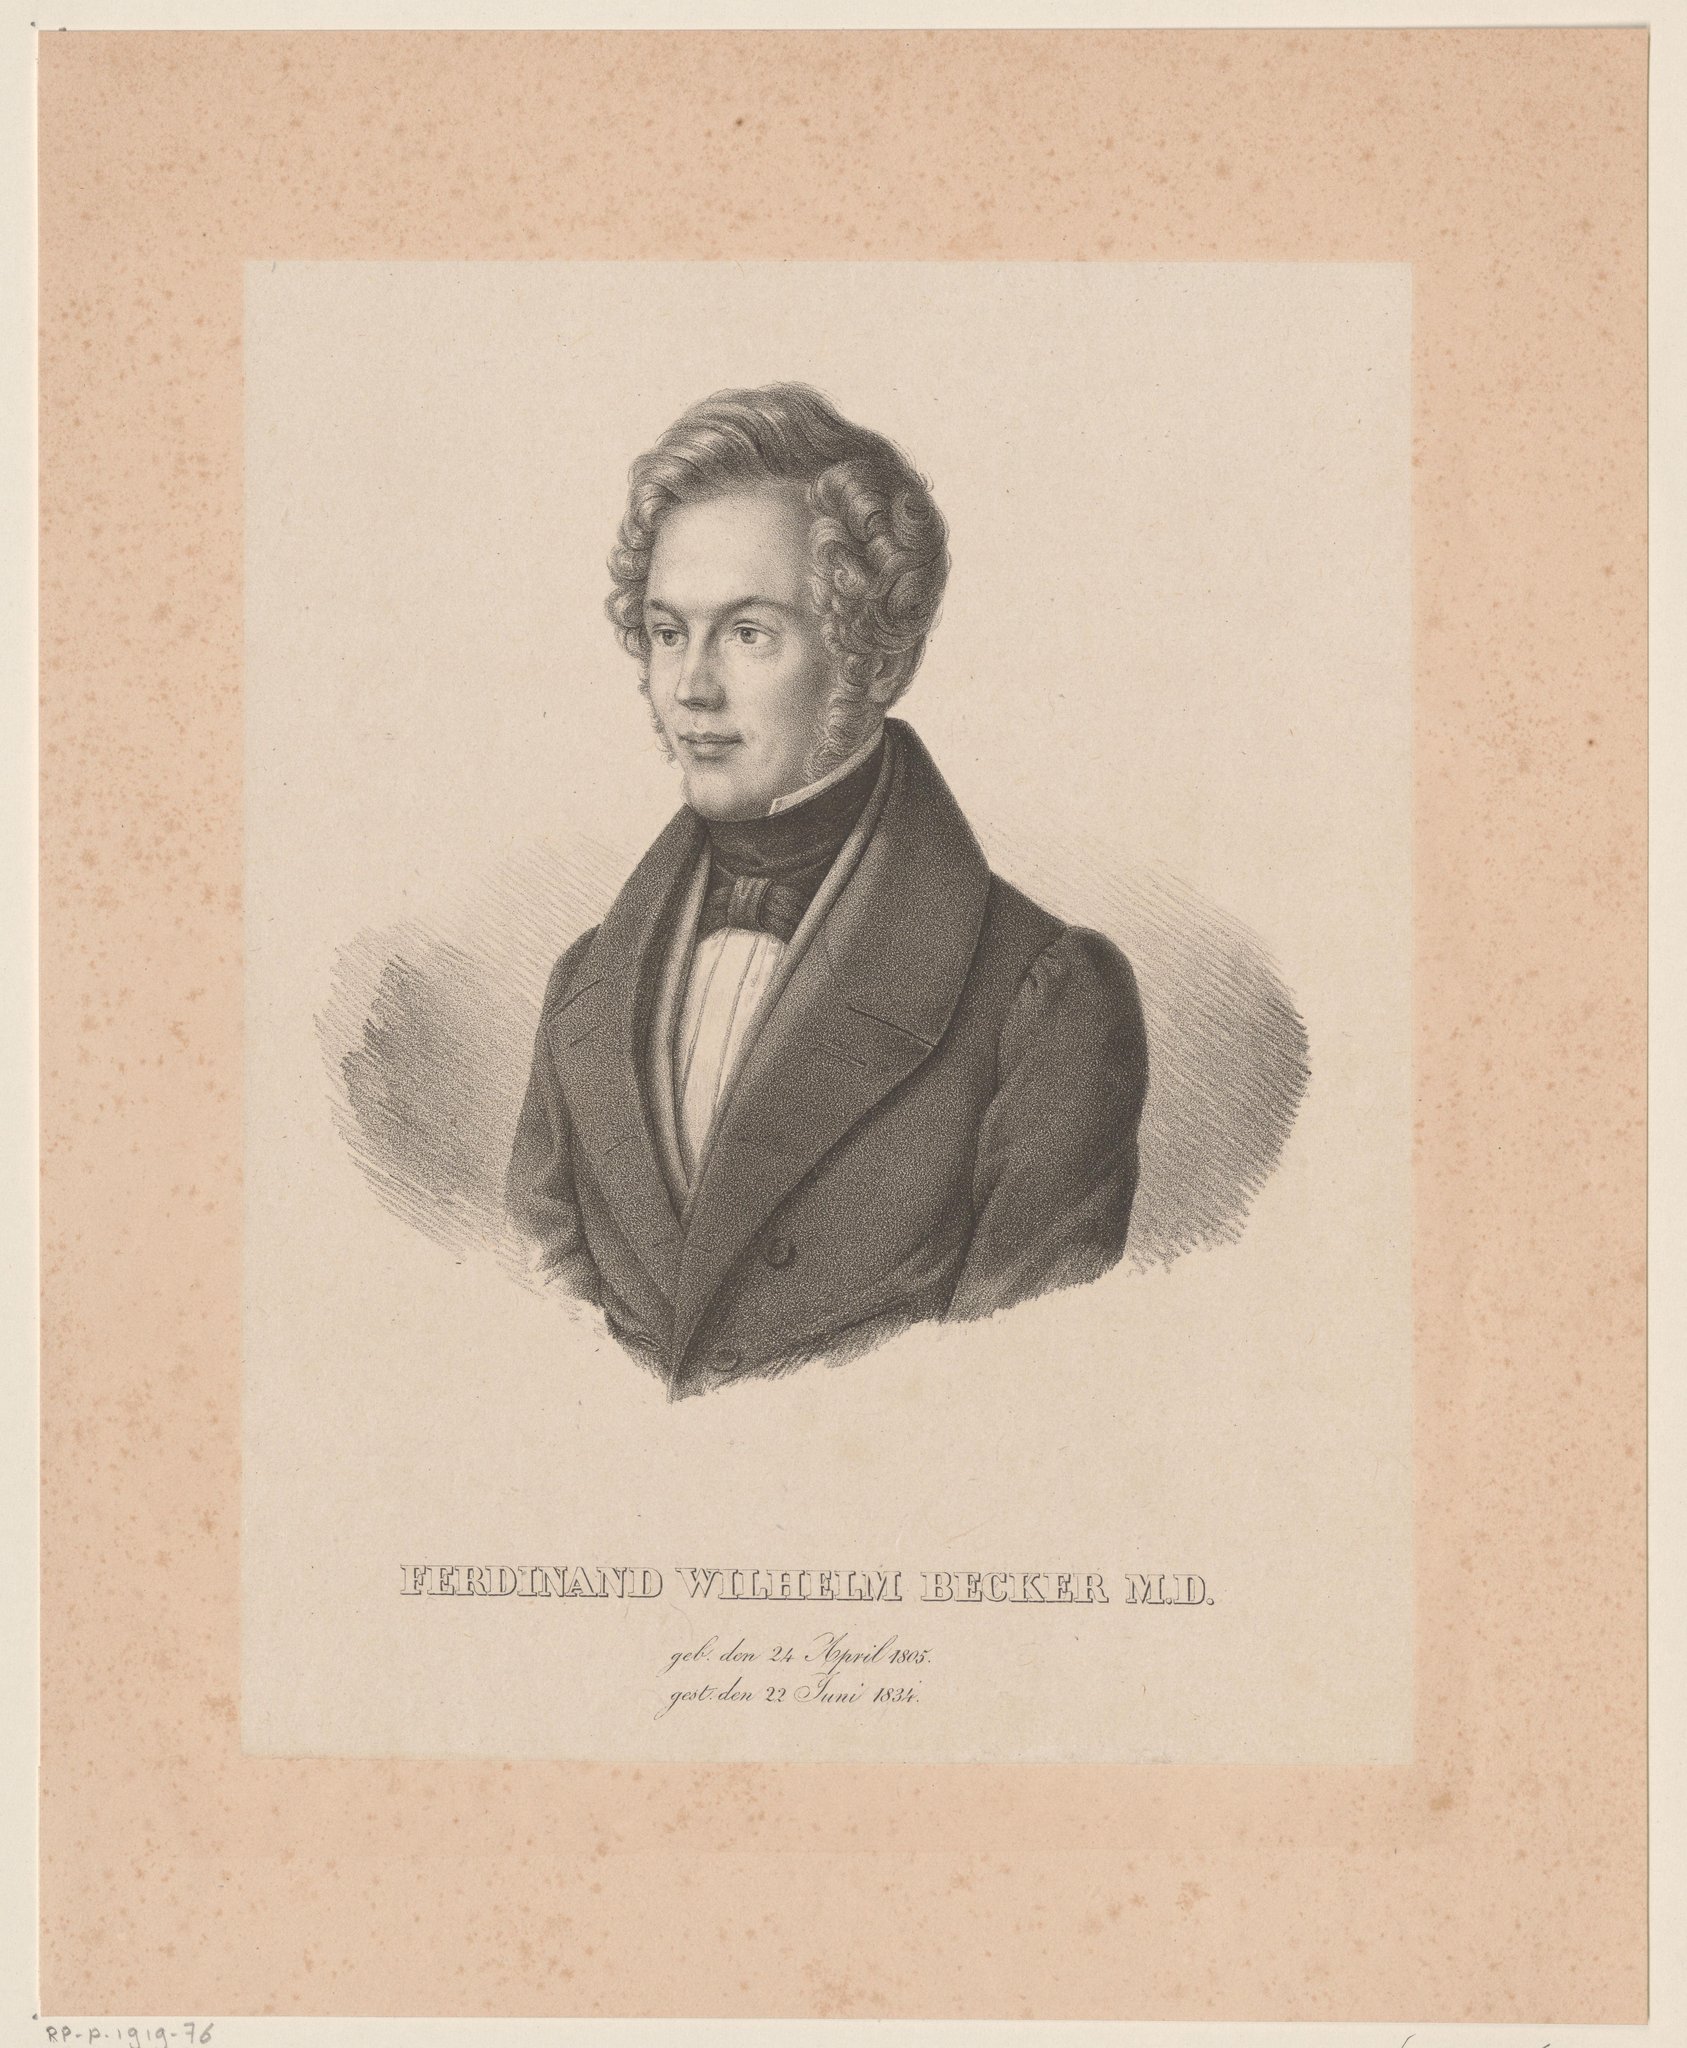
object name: print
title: Portret van Ferdinand Wilhelm Becker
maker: Anonymous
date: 1834-1849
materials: paper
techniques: lithograph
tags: historical persons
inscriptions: collector's mark: Lugt 2228